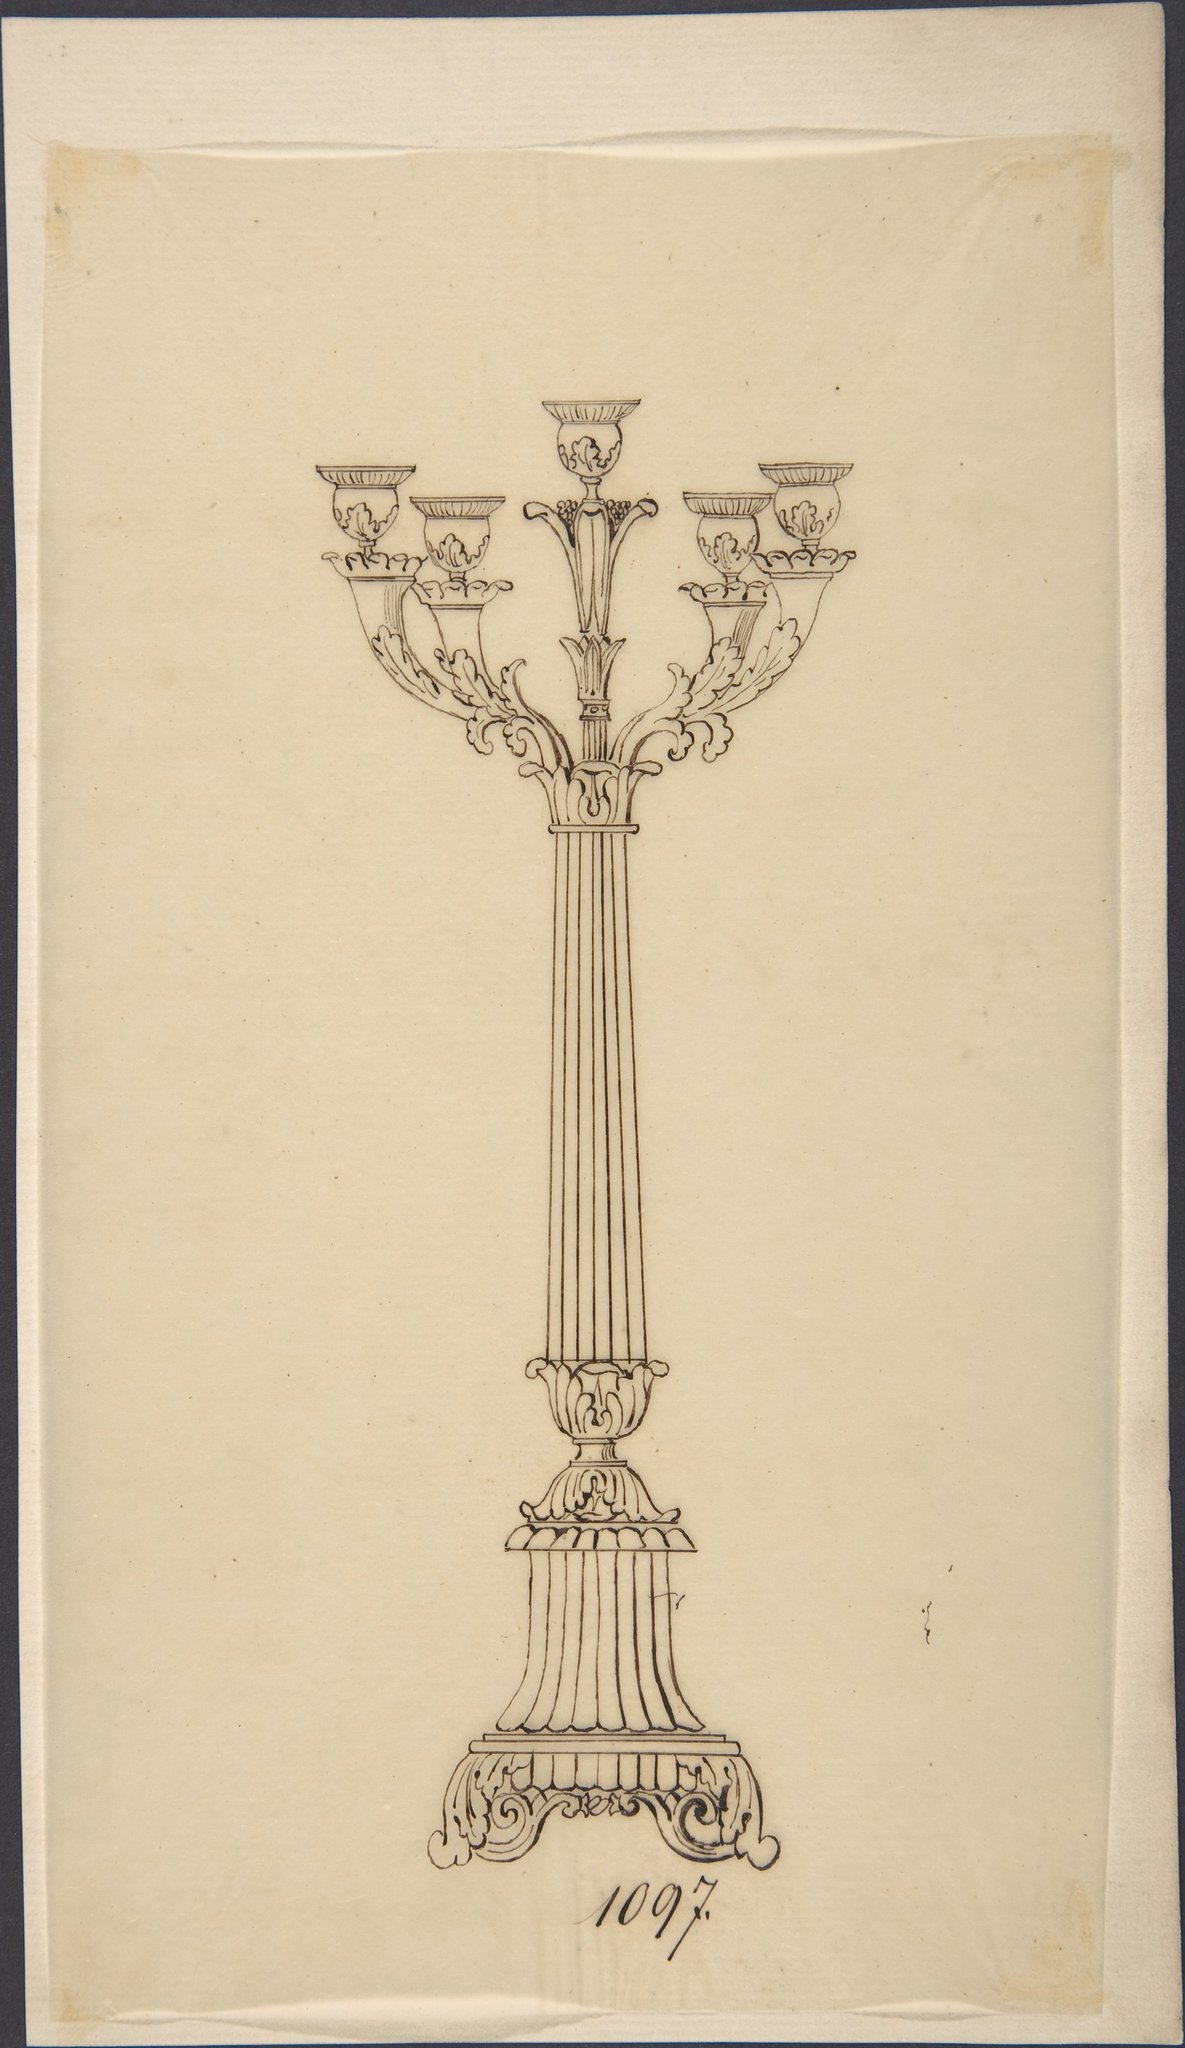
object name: drawing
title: Design for a Candelabra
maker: anonymous, french, 19th century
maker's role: artist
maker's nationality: french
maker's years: 1800-1900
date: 1801-1900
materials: ink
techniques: pen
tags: candelabra